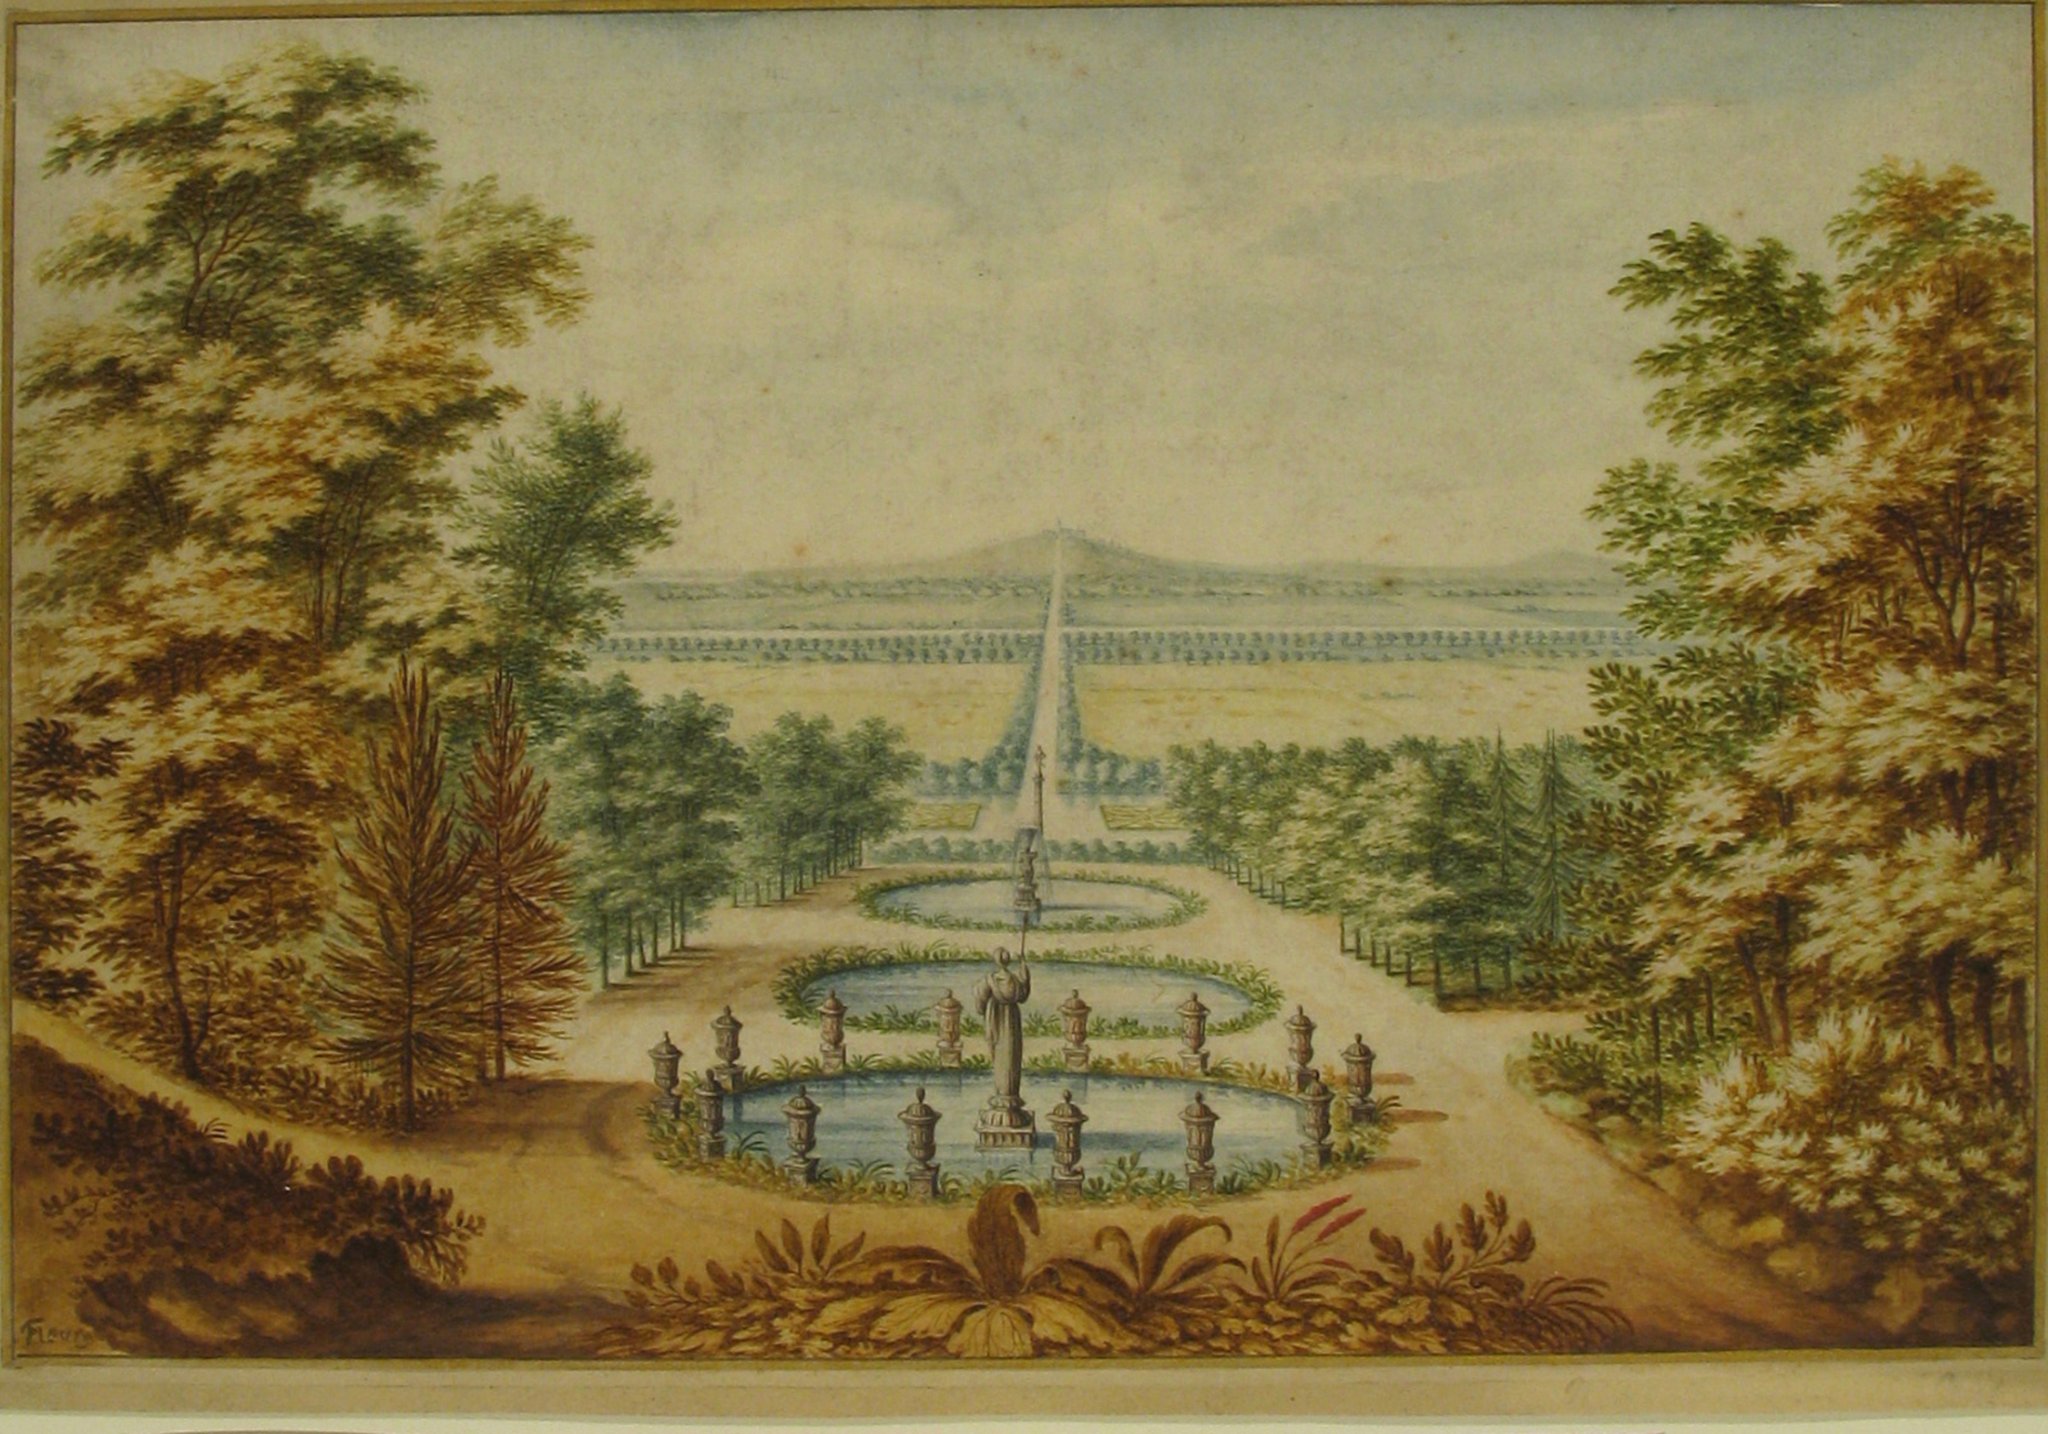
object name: drawing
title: Scenic View of Gardens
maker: antoine-claude fleury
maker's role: artist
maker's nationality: french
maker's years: 1795-1822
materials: gold, ink, watercolor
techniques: brush, pen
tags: fountains,gardens,landscapes